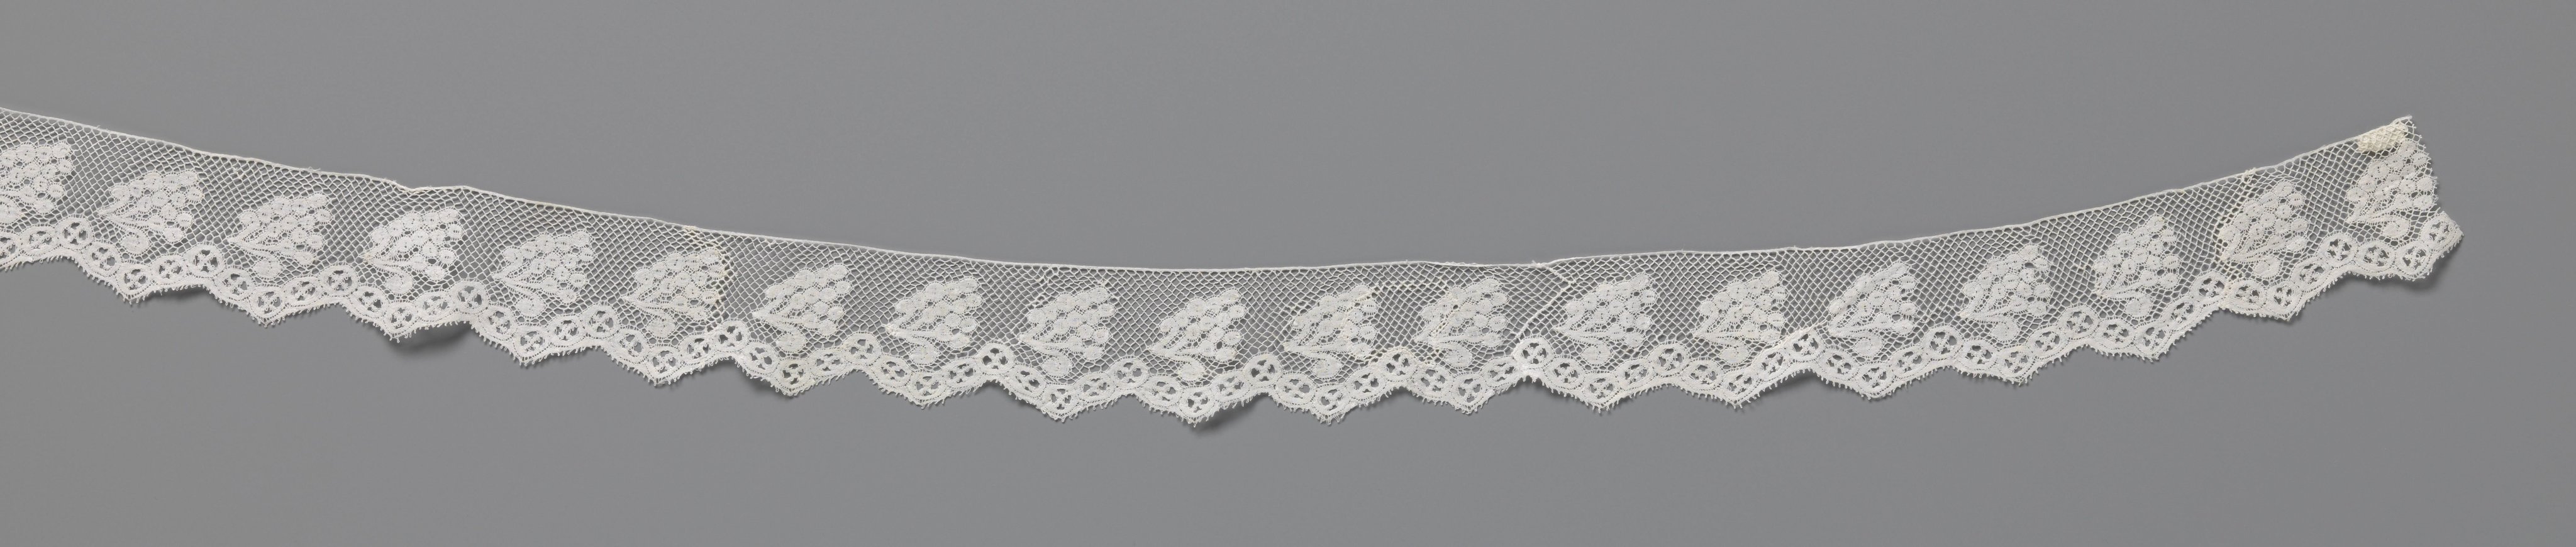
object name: strip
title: Strook kloskant met bloemtrosjes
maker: Anonymous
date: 1910-1920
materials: linen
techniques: lace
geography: netherlands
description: Op een mazenfond (vierkante mazen) staan eenzijdig gerichte strookjes van drie bloemen boven een zigzag-schulprand met aaneengeschakelde radertjes. Valenciennes-kant.